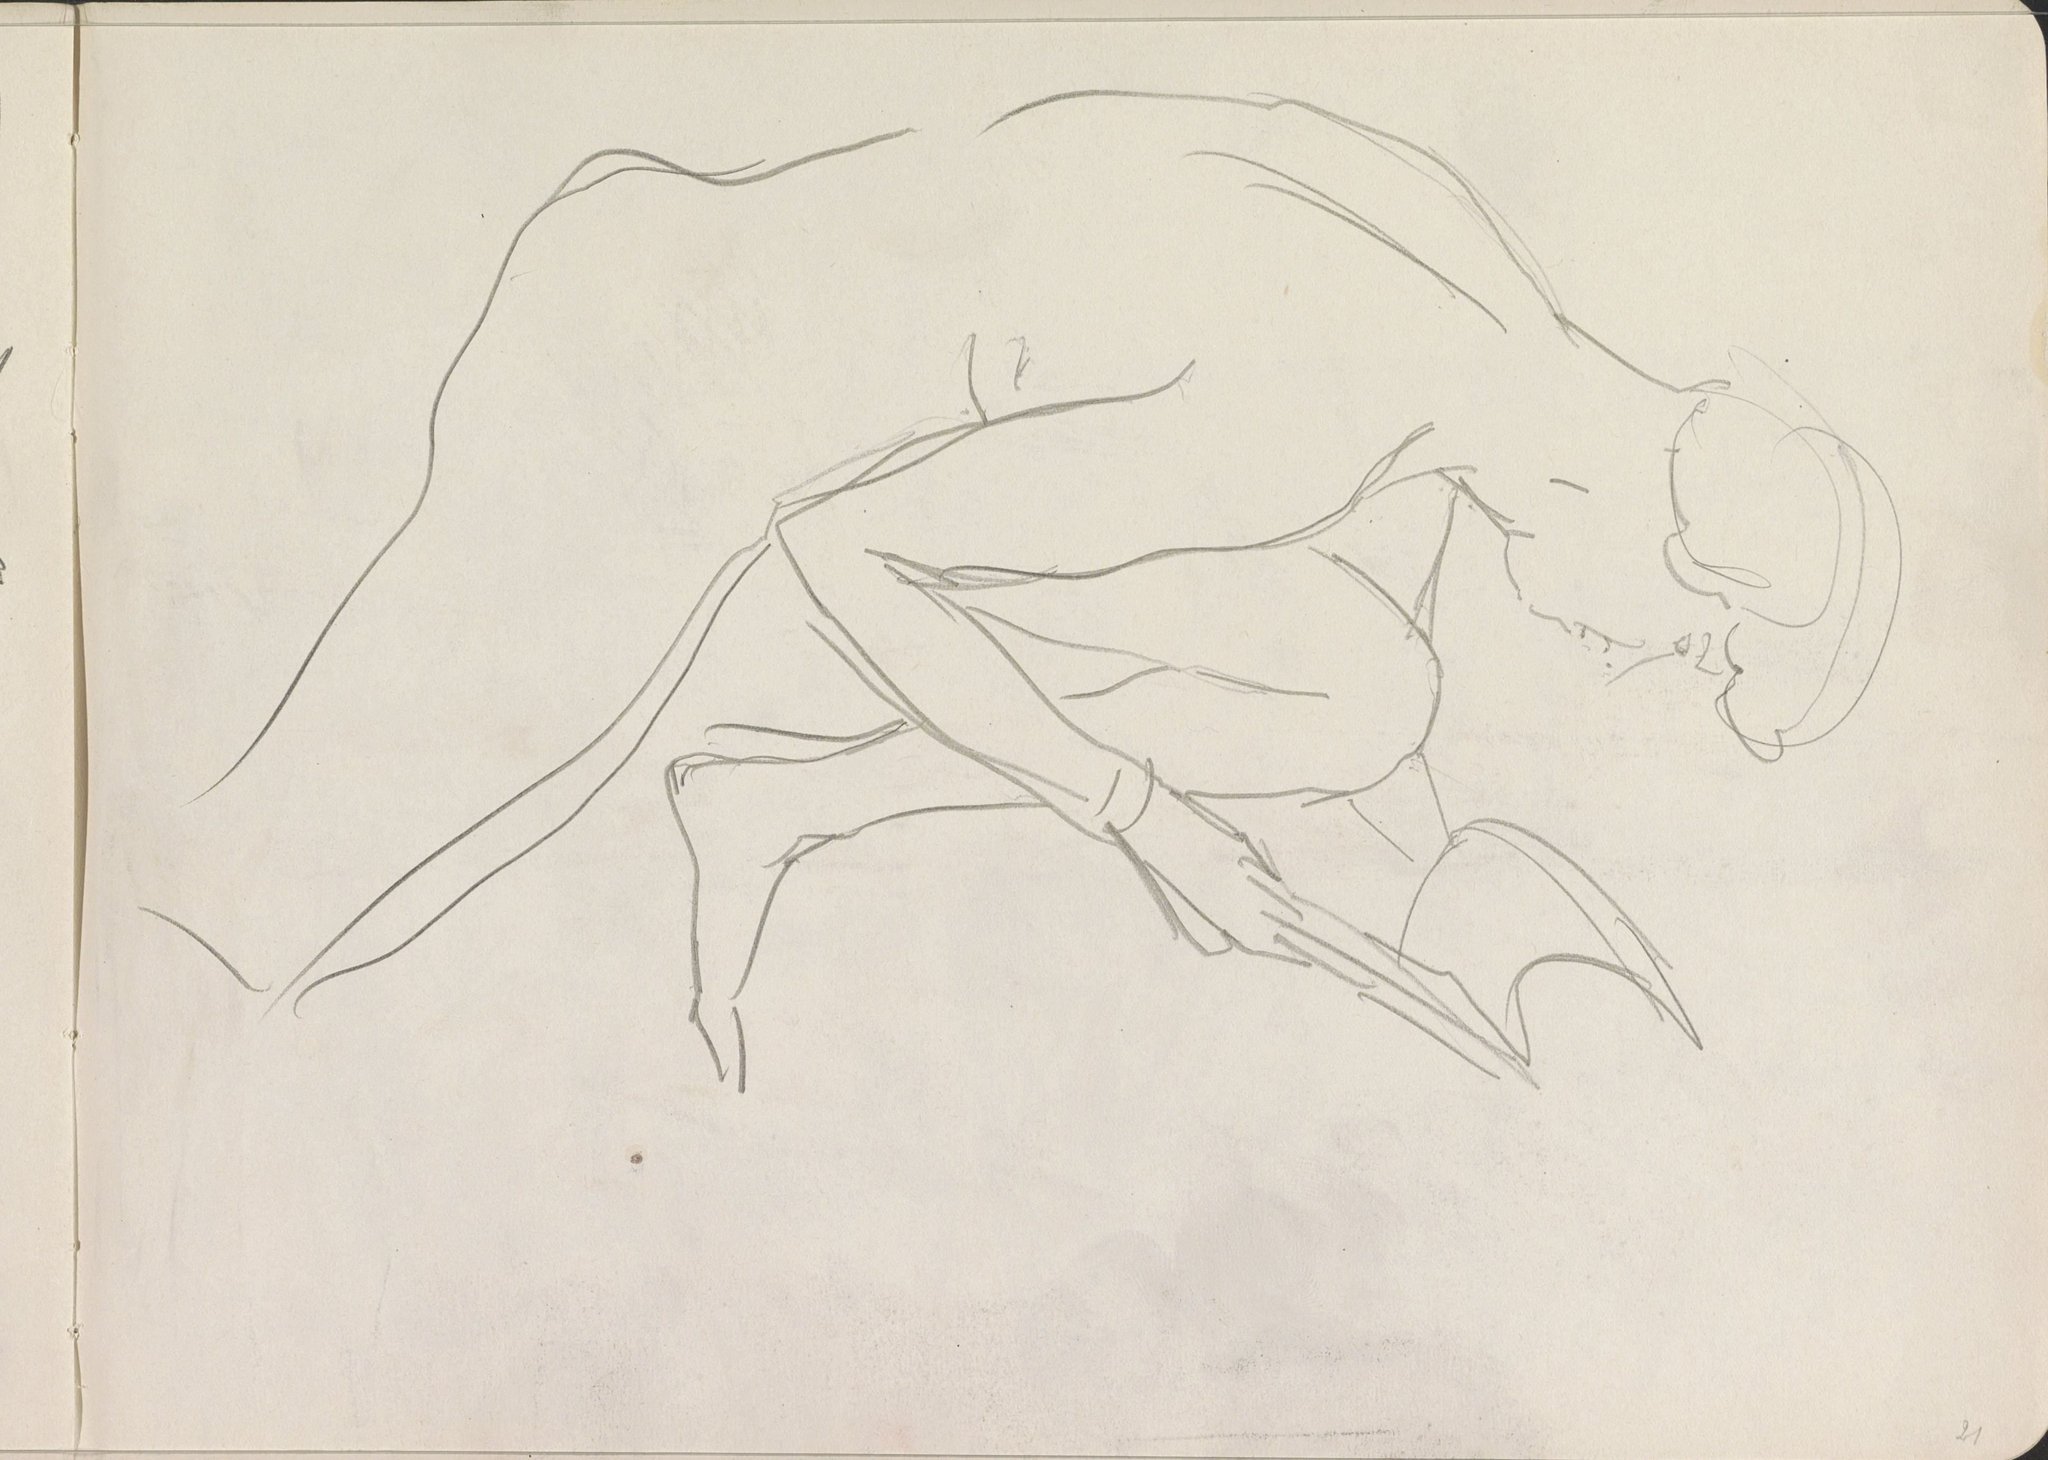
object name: sketchbook leaf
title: Zittend vrouwelijk naakt, lezend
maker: isaac israels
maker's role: draughtsman, painter, print maker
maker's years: 1865-1934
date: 1875-1934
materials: paper, pencil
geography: the hague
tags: the (nude) human figure; 'corpo humano' (ripa) - aa - female human figure (+ sitting), reading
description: Met een opgetrokken been. Blad 21 recto uit schetsboek II met 23 bladen.